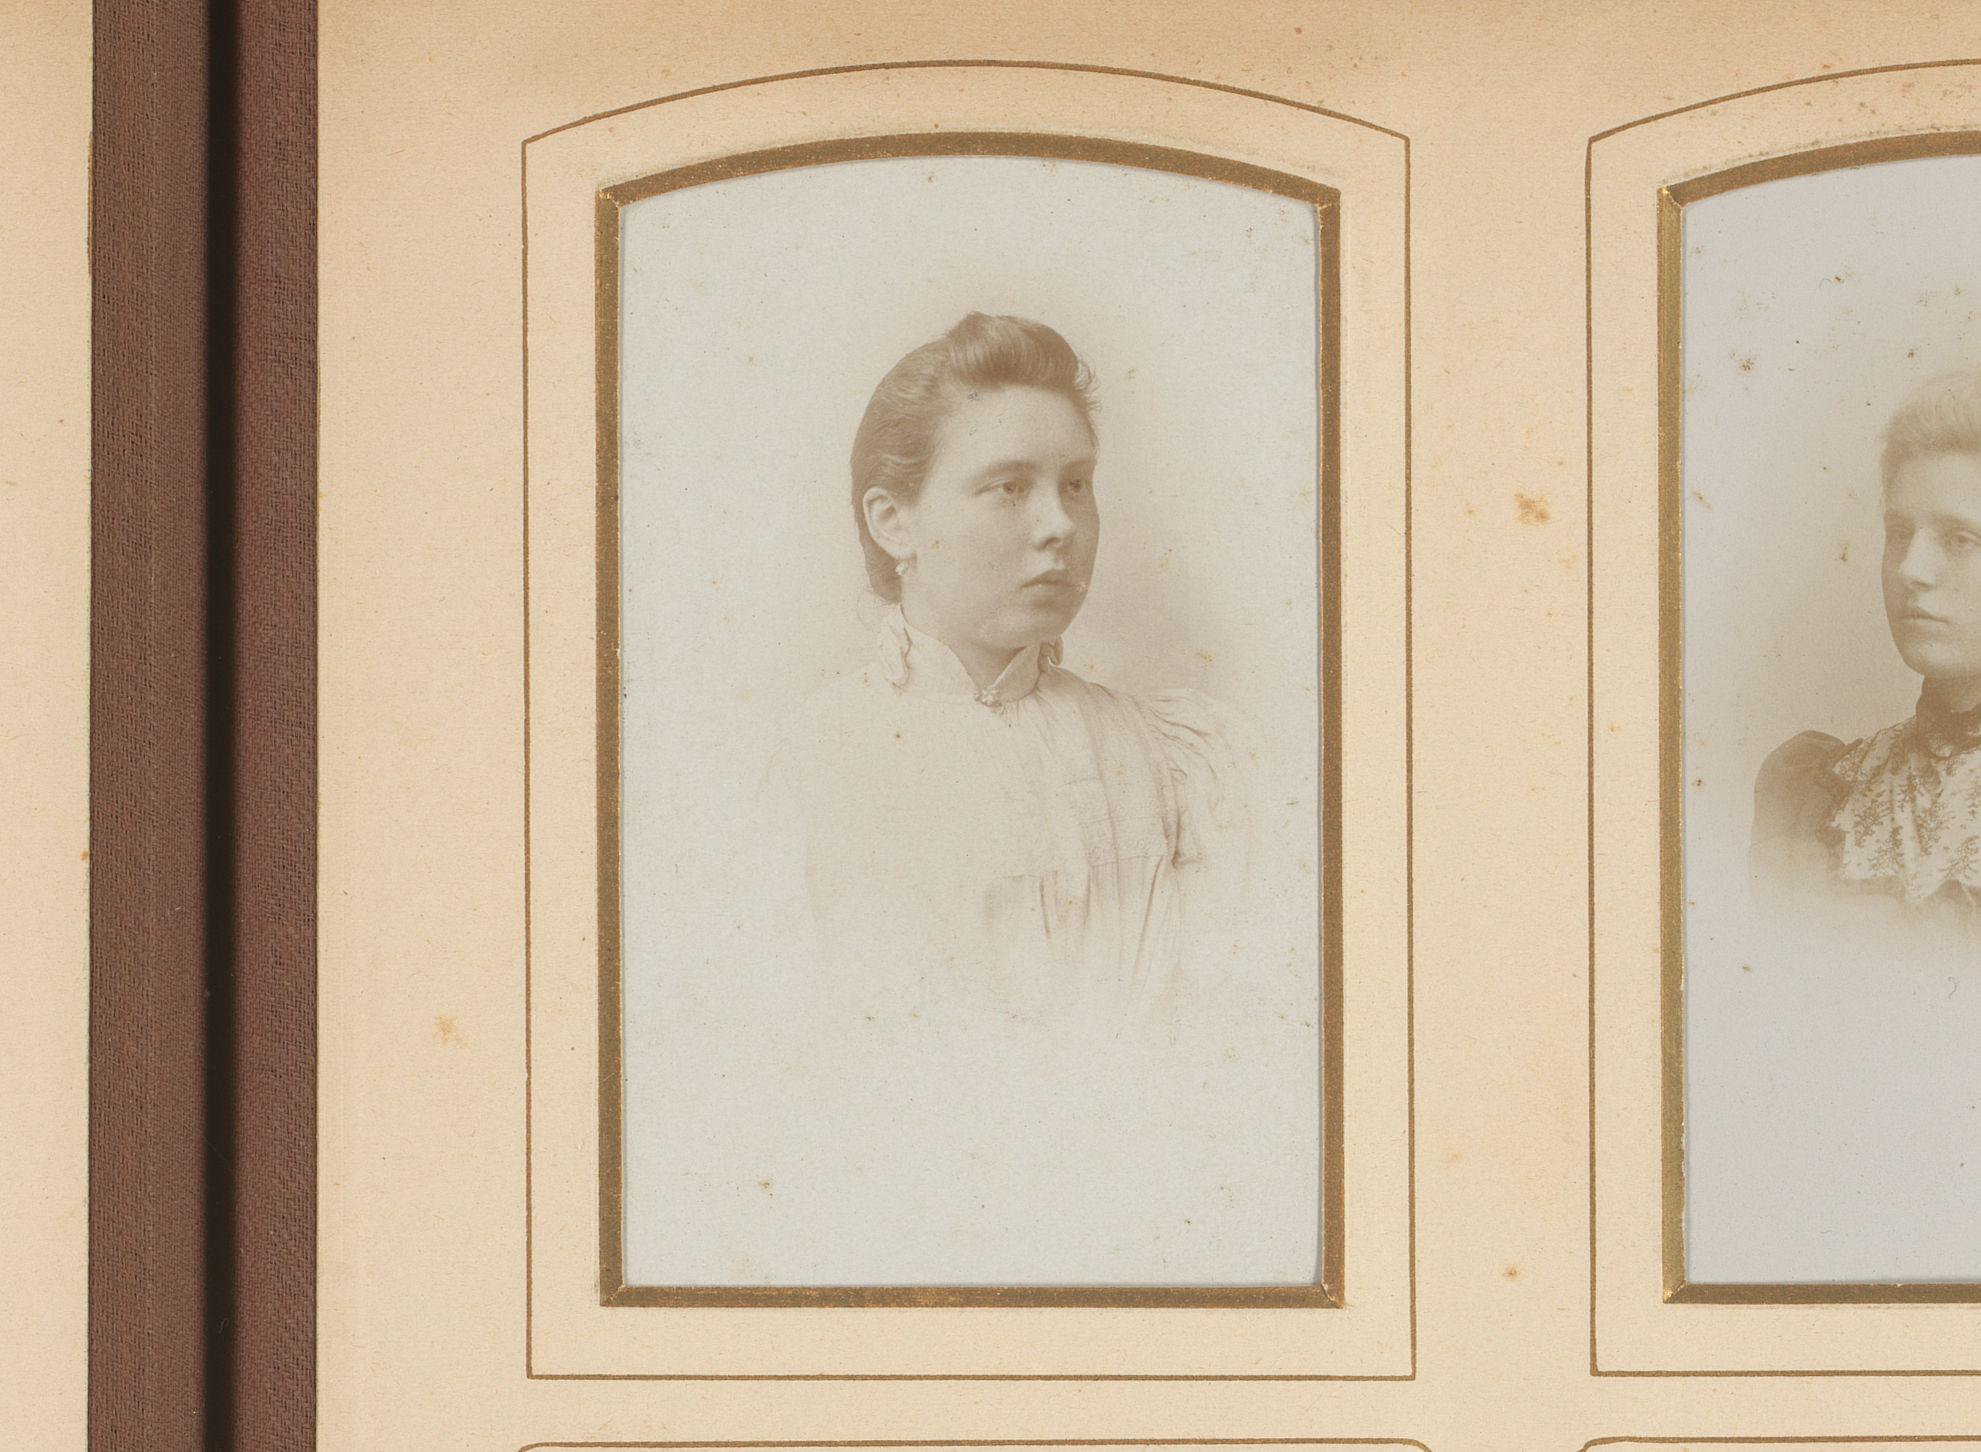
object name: album leaf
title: Portret van een jonge vrouw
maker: h. van der zijl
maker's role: fotograaf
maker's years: 1852-1937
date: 1886-1908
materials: cardboard, photographic support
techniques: collodion silver print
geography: amsterdam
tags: adolescent, young woman, maiden, historical persons - bb - woman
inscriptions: inscription: ‘Photographie/ Parisienne/ H. van der Zijl/ Amsterdam/ 60 Nieuwendijk 60./ over Raamskooi en Kapelsteeg./ Gelieve op Voornaam H/ en Huisnummer 60 te Letten’